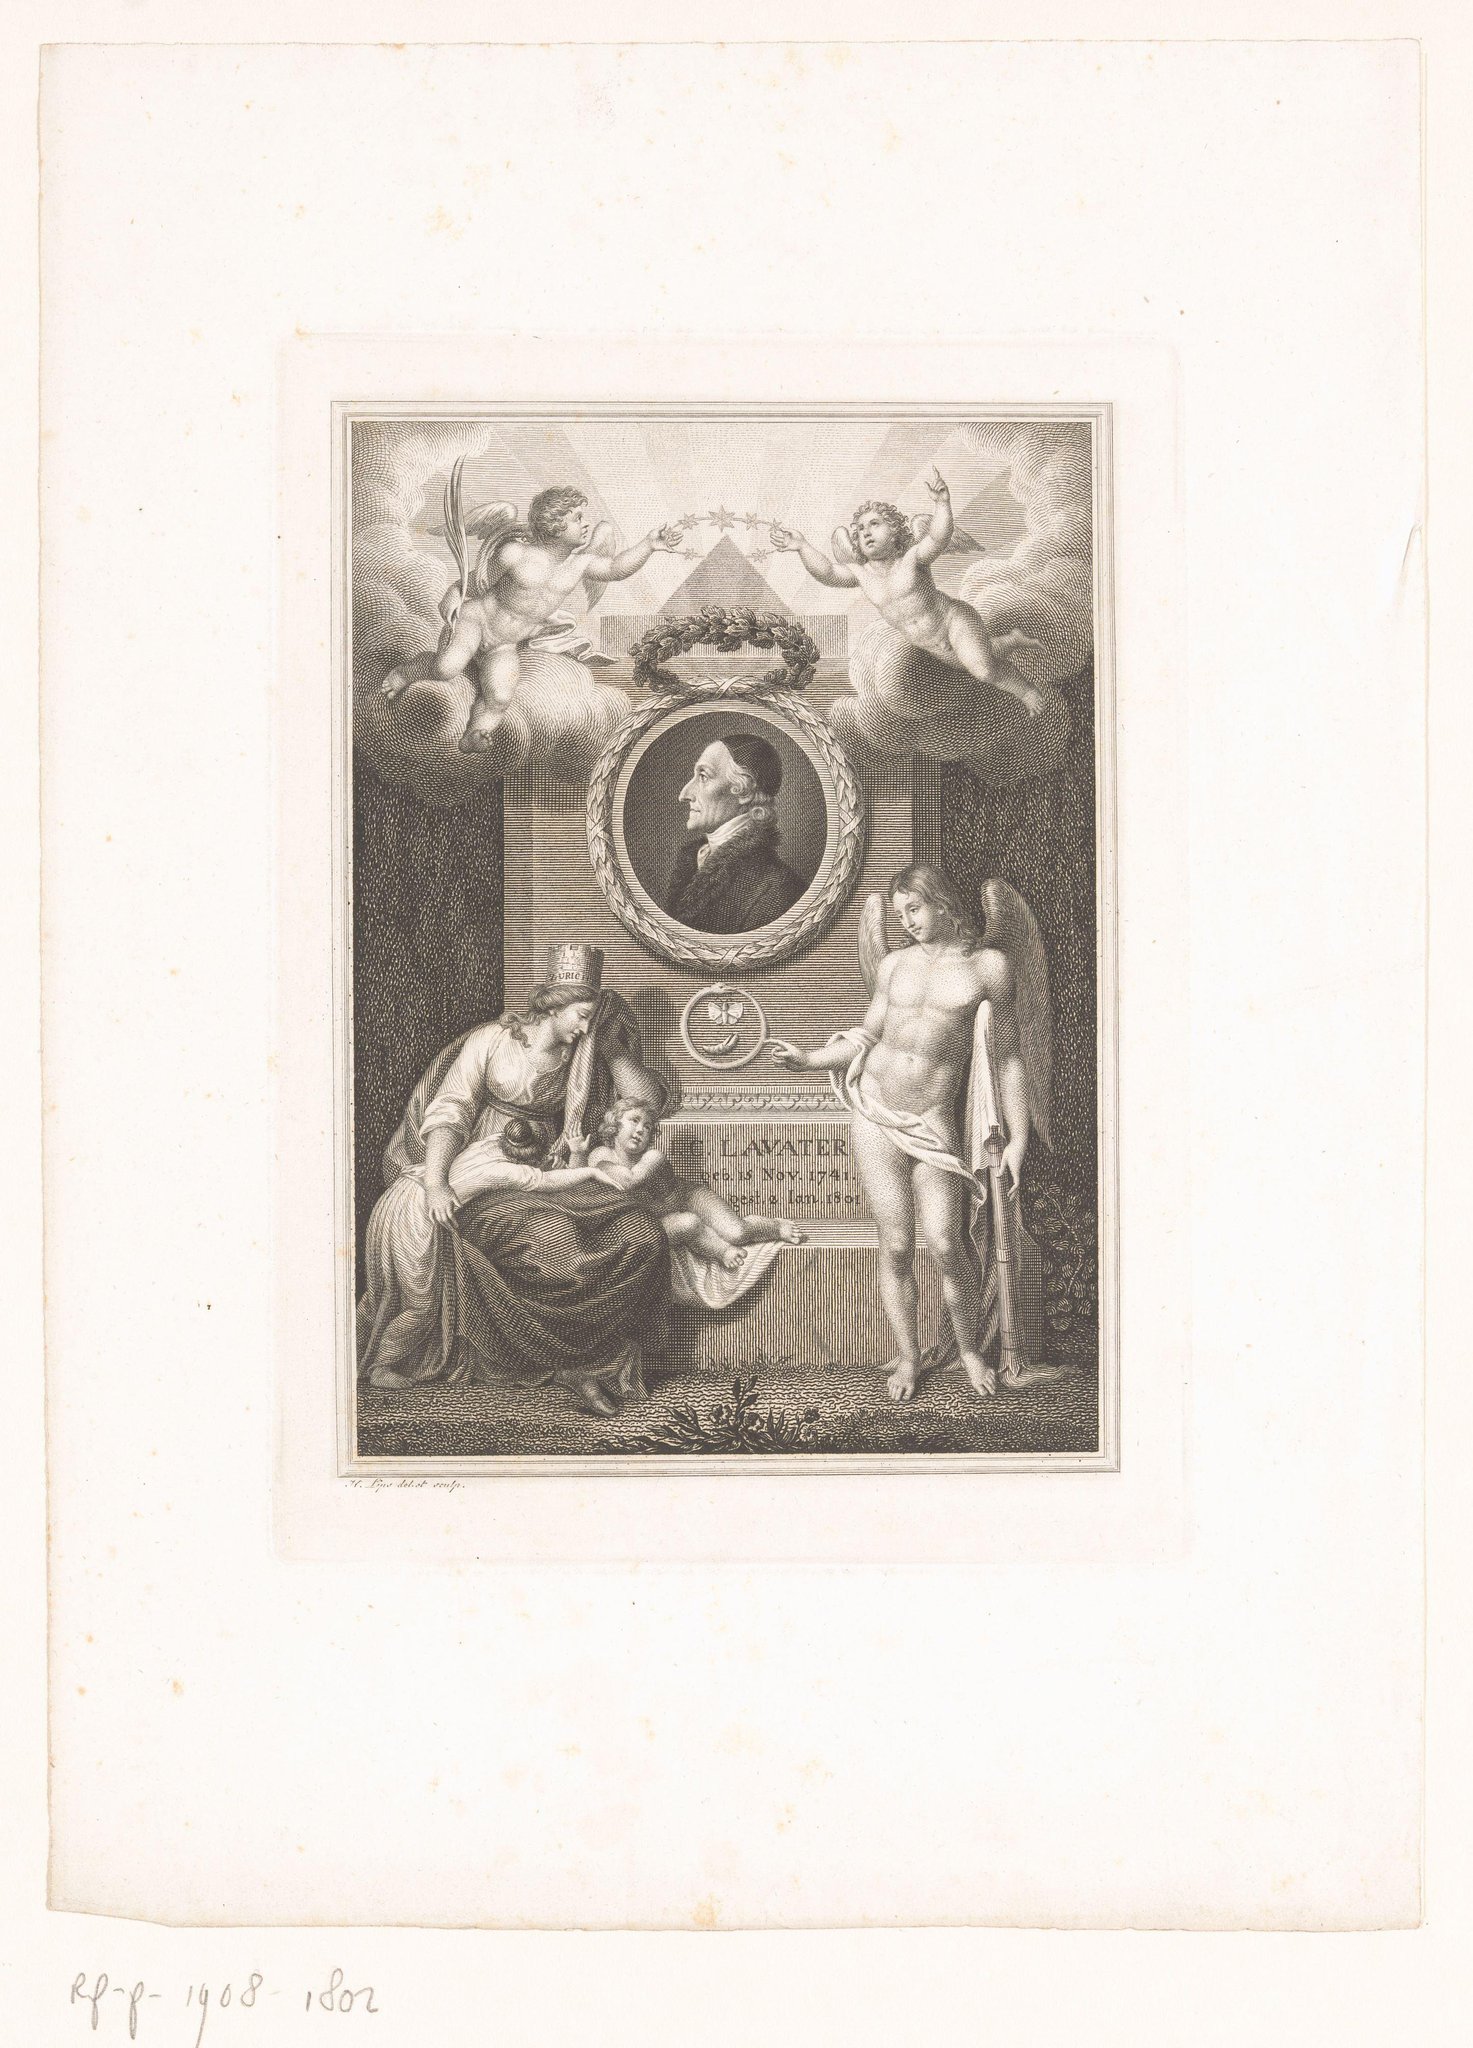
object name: print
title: Grafmonument met portret van Johann Kaspar Lavater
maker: johann heinrich lips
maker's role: draughtsman, painter, print maker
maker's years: 1758-1817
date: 1801-1817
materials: paper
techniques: engraving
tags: johann caspar lavater, historical persons, portrait of a writer, grave-building, monumental tomb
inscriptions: collector's mark: Lugt 2228